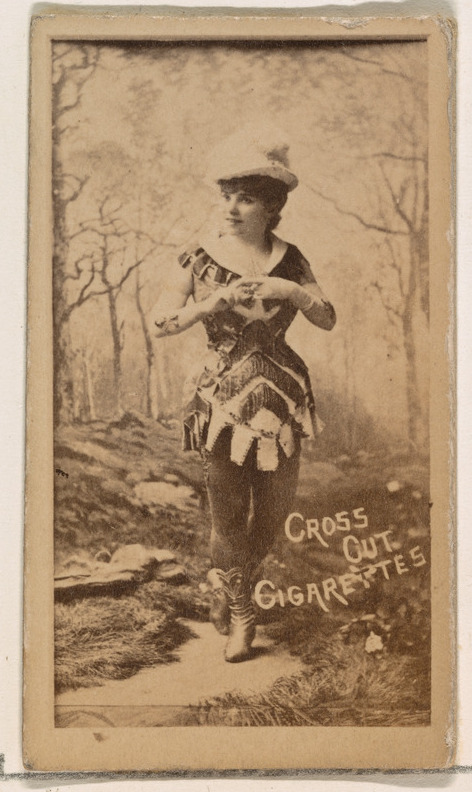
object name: print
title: Actress posing in studio forest scene, from the Actors and Actresses series (N145-1) issued by Duke Sons & Co. to promote Cross Cut Cigarettes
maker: w. duke, sons & co.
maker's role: publisher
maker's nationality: american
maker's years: 1870-1920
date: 1880-1889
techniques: albumen silver print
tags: portraits,women,actresses